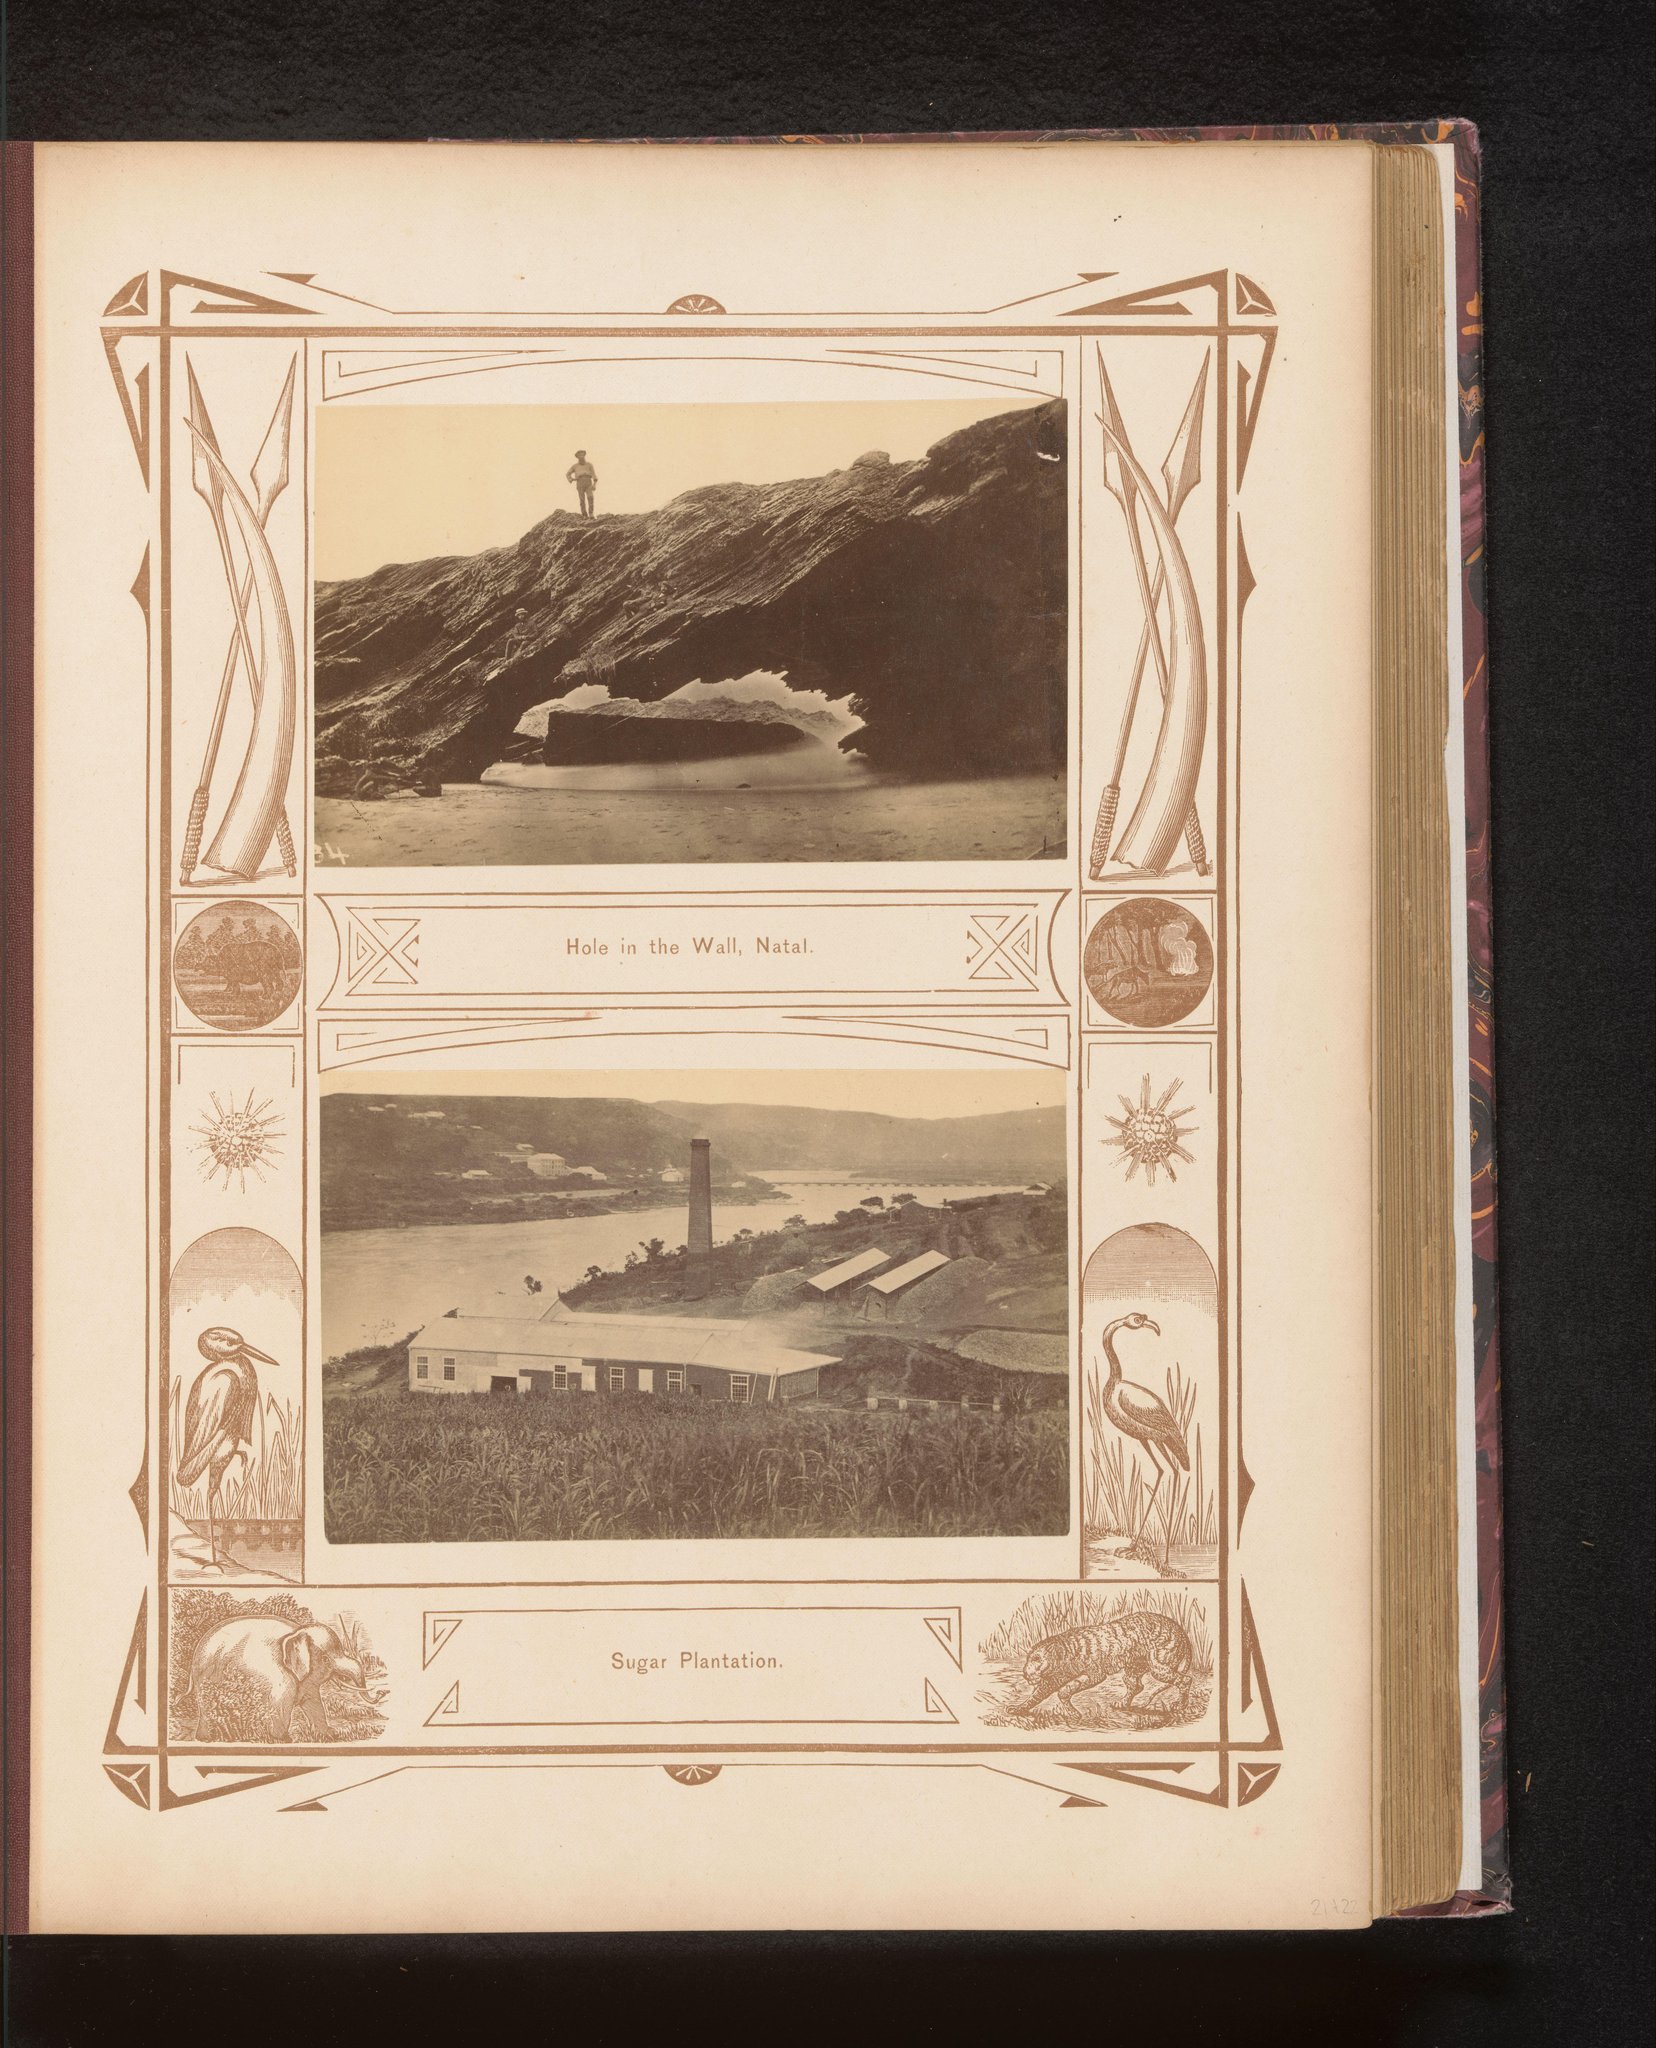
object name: photograph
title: Onbekende Europese man op een rots bij Hole in the wall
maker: Anonymous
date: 1877-1882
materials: photographic support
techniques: albumen print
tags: historical persons, landscapes with waters, waterscapes, seascapes (in the temperate zone), rocks